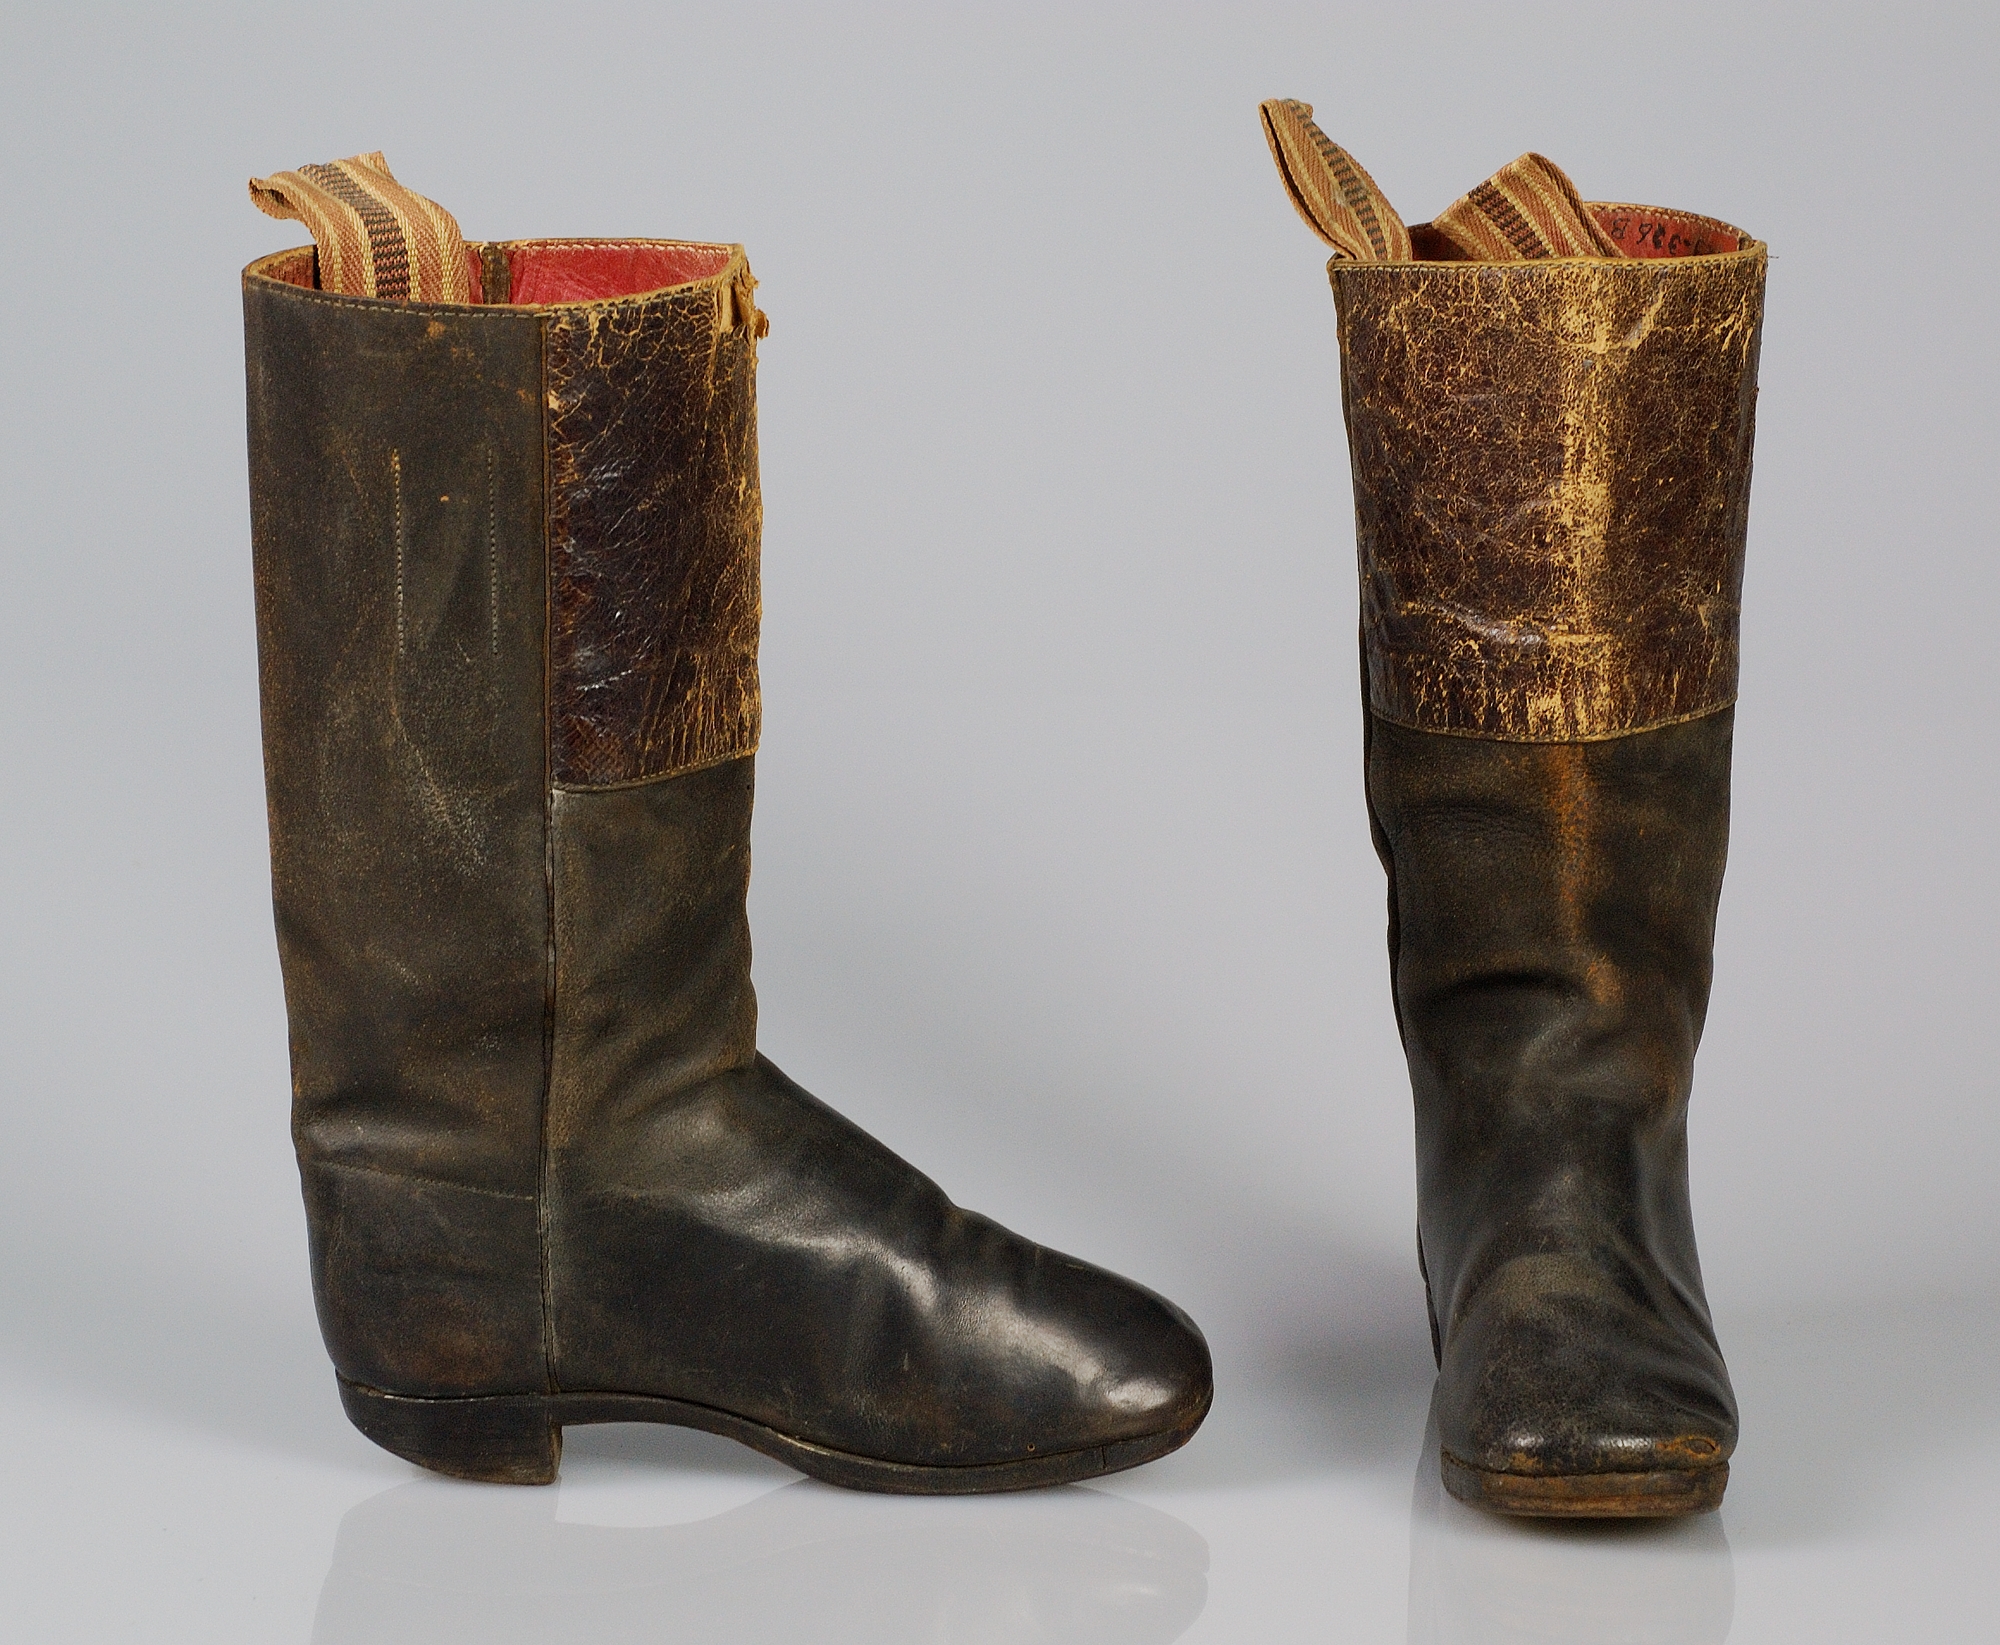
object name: boot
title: Boots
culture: american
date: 1855-1869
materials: leather, wood